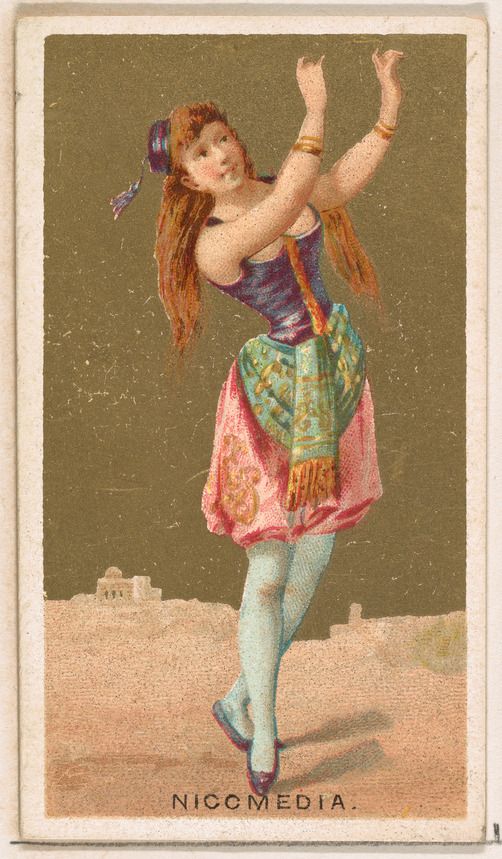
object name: print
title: Nicomedia, from the Dancing Girls of the World series (N185) issued by Wm. S. Kimball & Co.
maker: william s. kimball & company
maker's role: publisher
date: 1889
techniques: color lithograph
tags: women,dancers